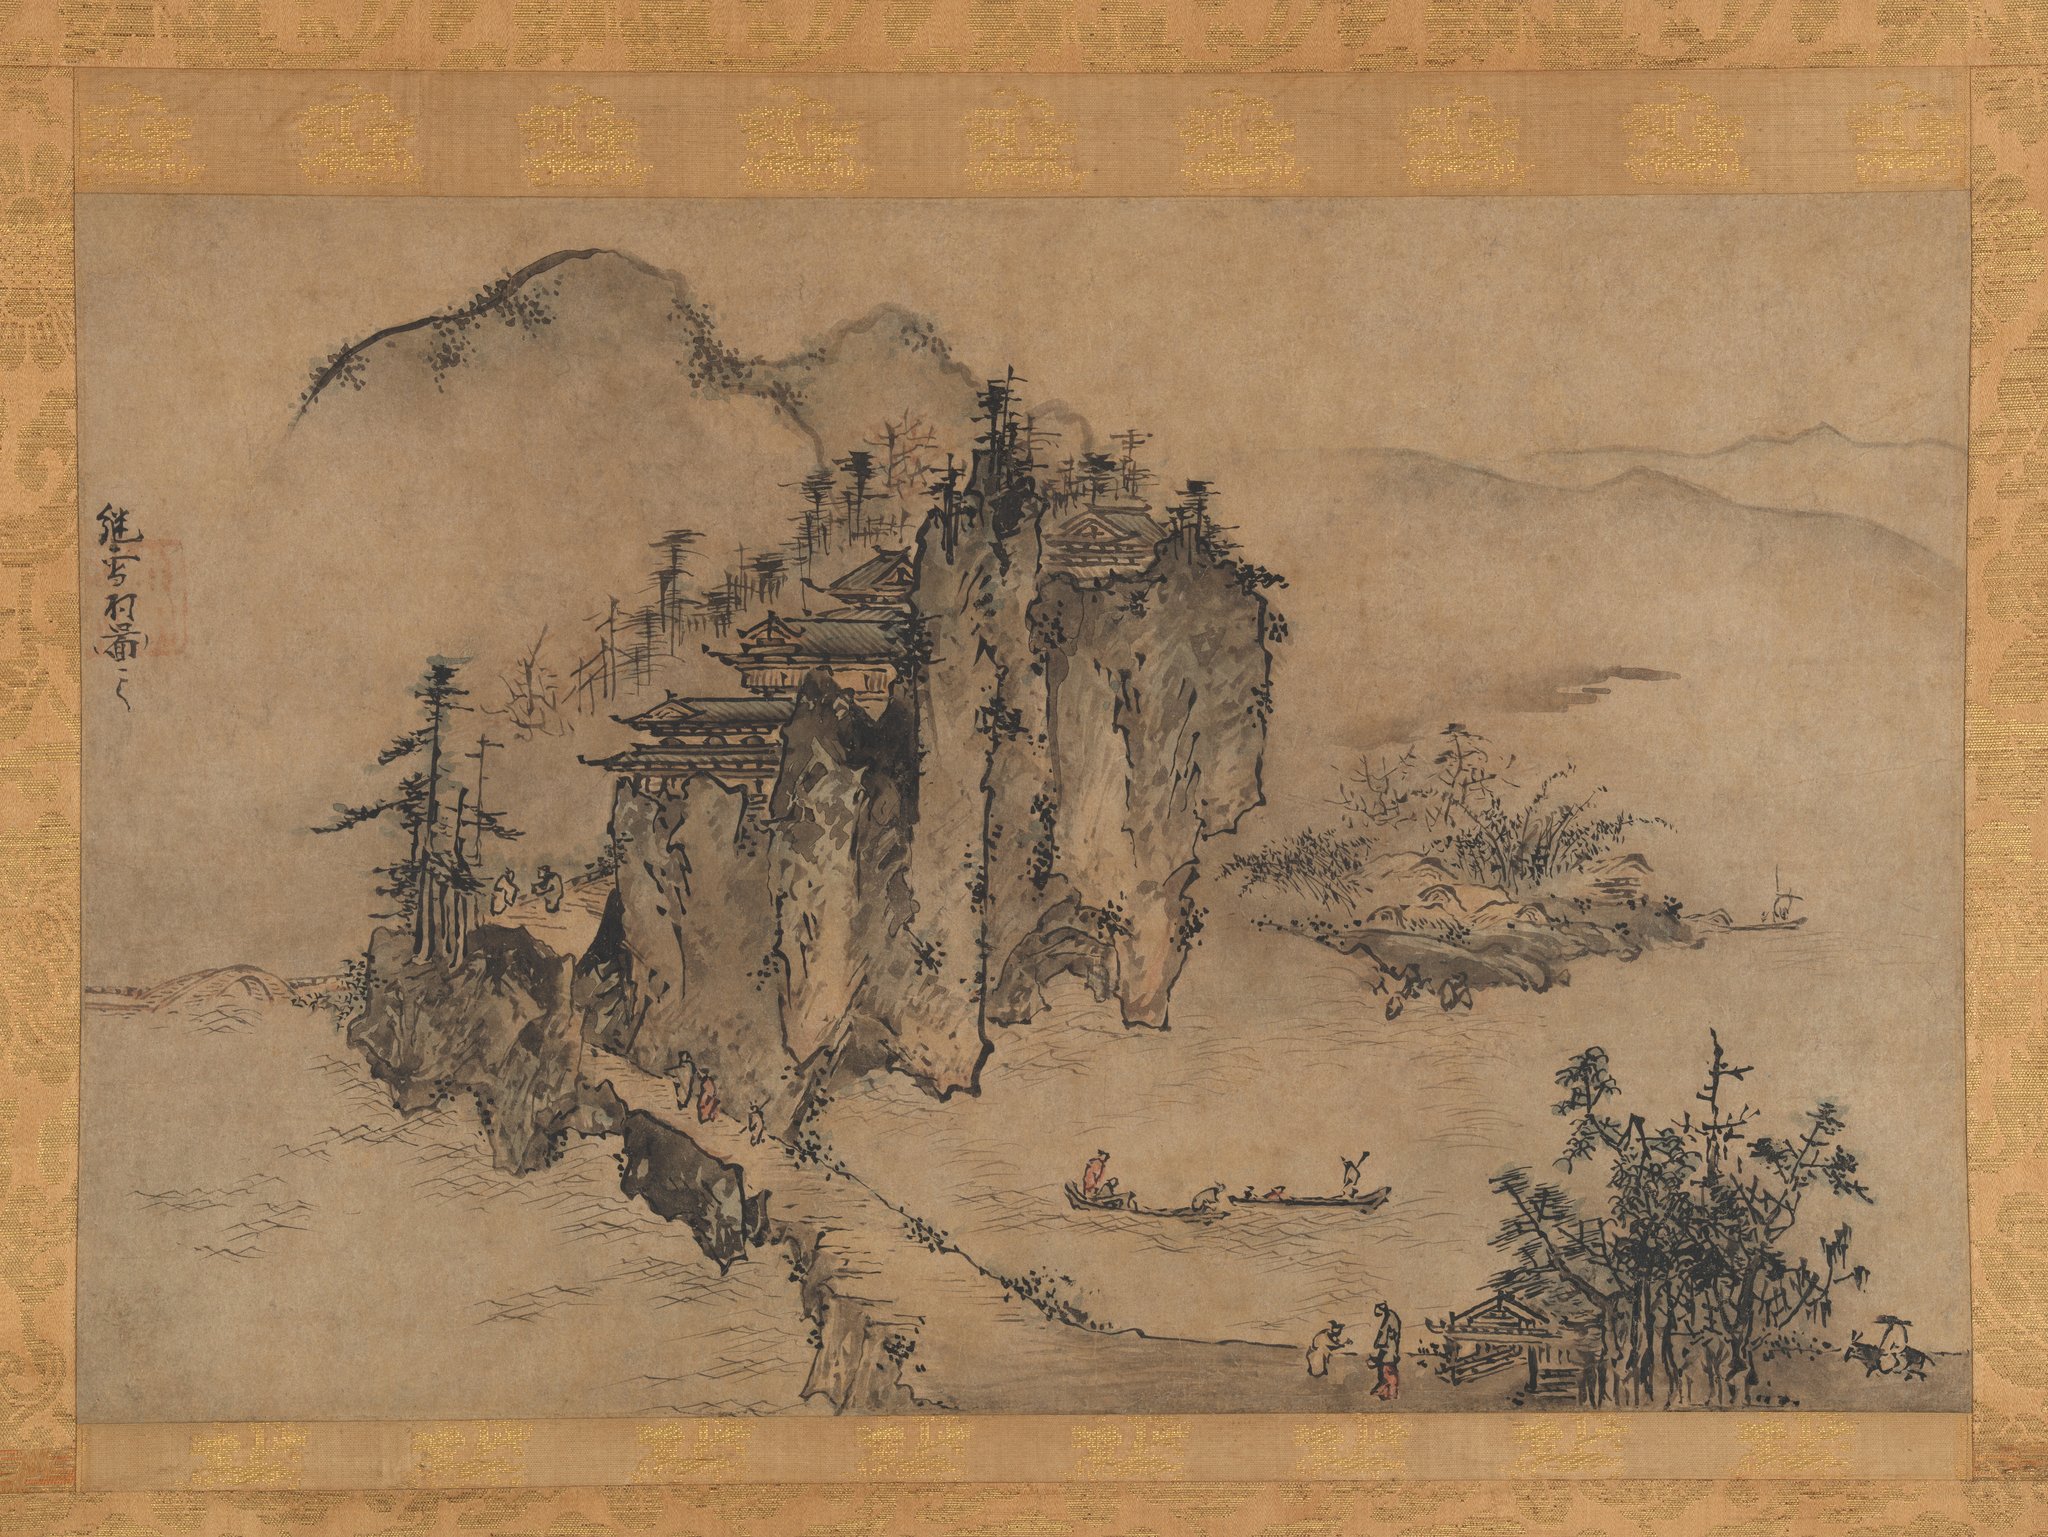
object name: hanging scroll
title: Landscape with Rocky Precipice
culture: japanese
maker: sesson shūkei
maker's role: artist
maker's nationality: japanese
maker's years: 1504-1589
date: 1501-1600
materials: ink, paper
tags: landscapes